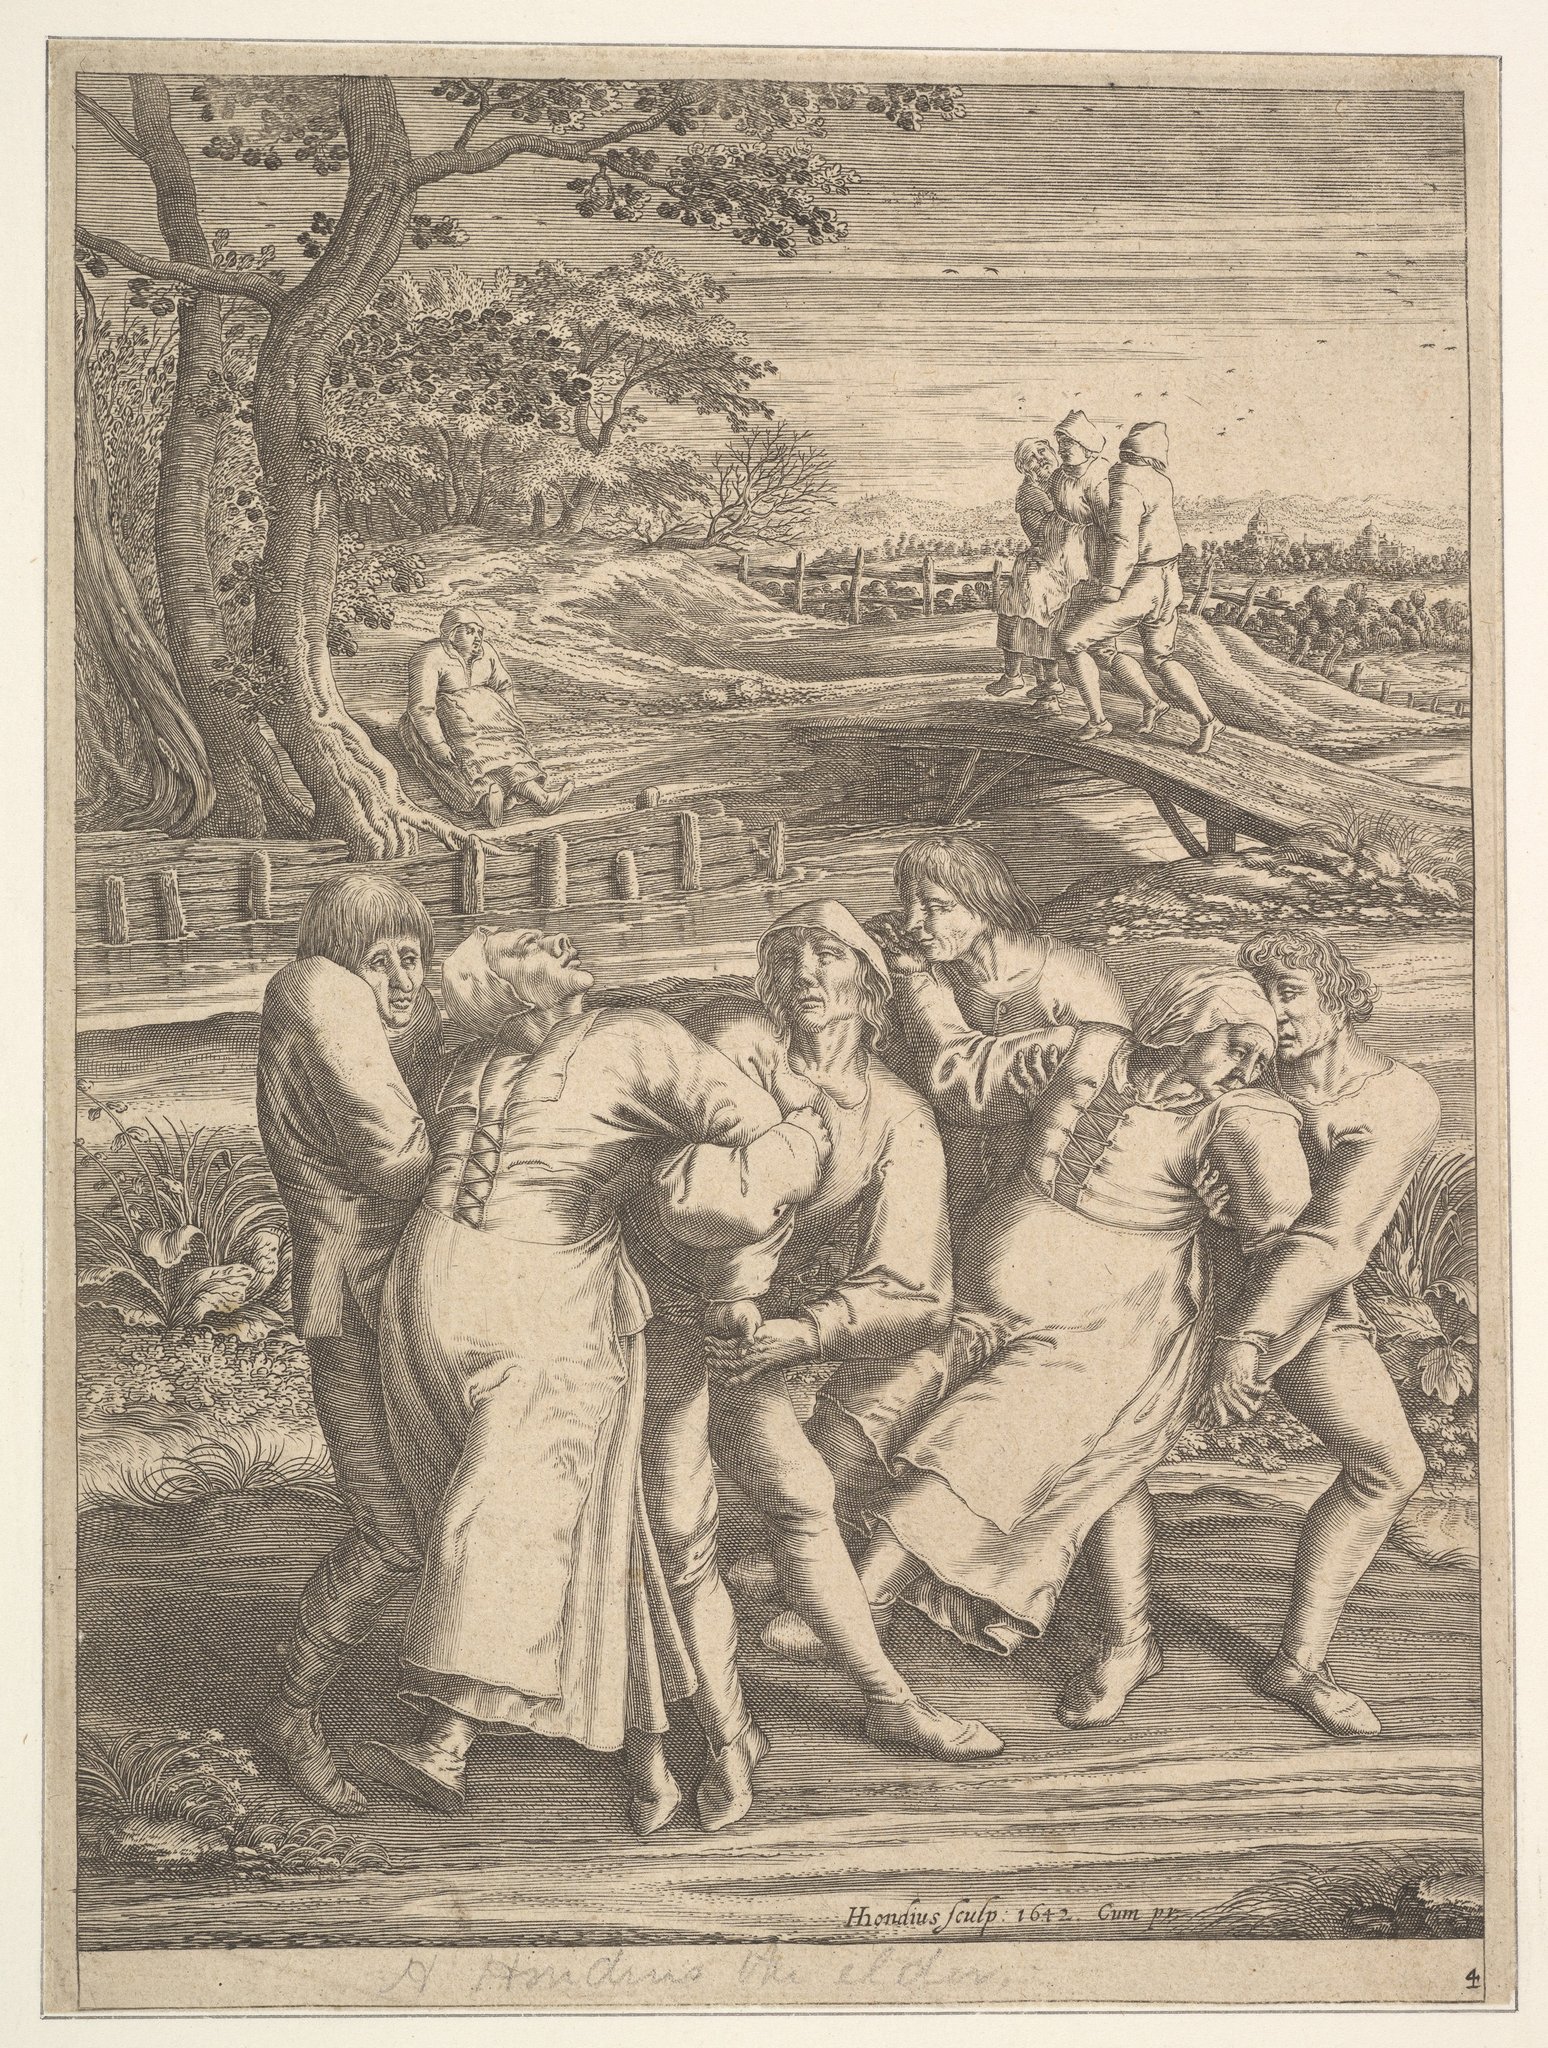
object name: print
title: Epileptics Walking to the Left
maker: hendrick hondius (i)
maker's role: artist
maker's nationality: netherlandish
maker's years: 1573-1650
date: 1642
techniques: engraving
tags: bridges,illness,men,women,walking